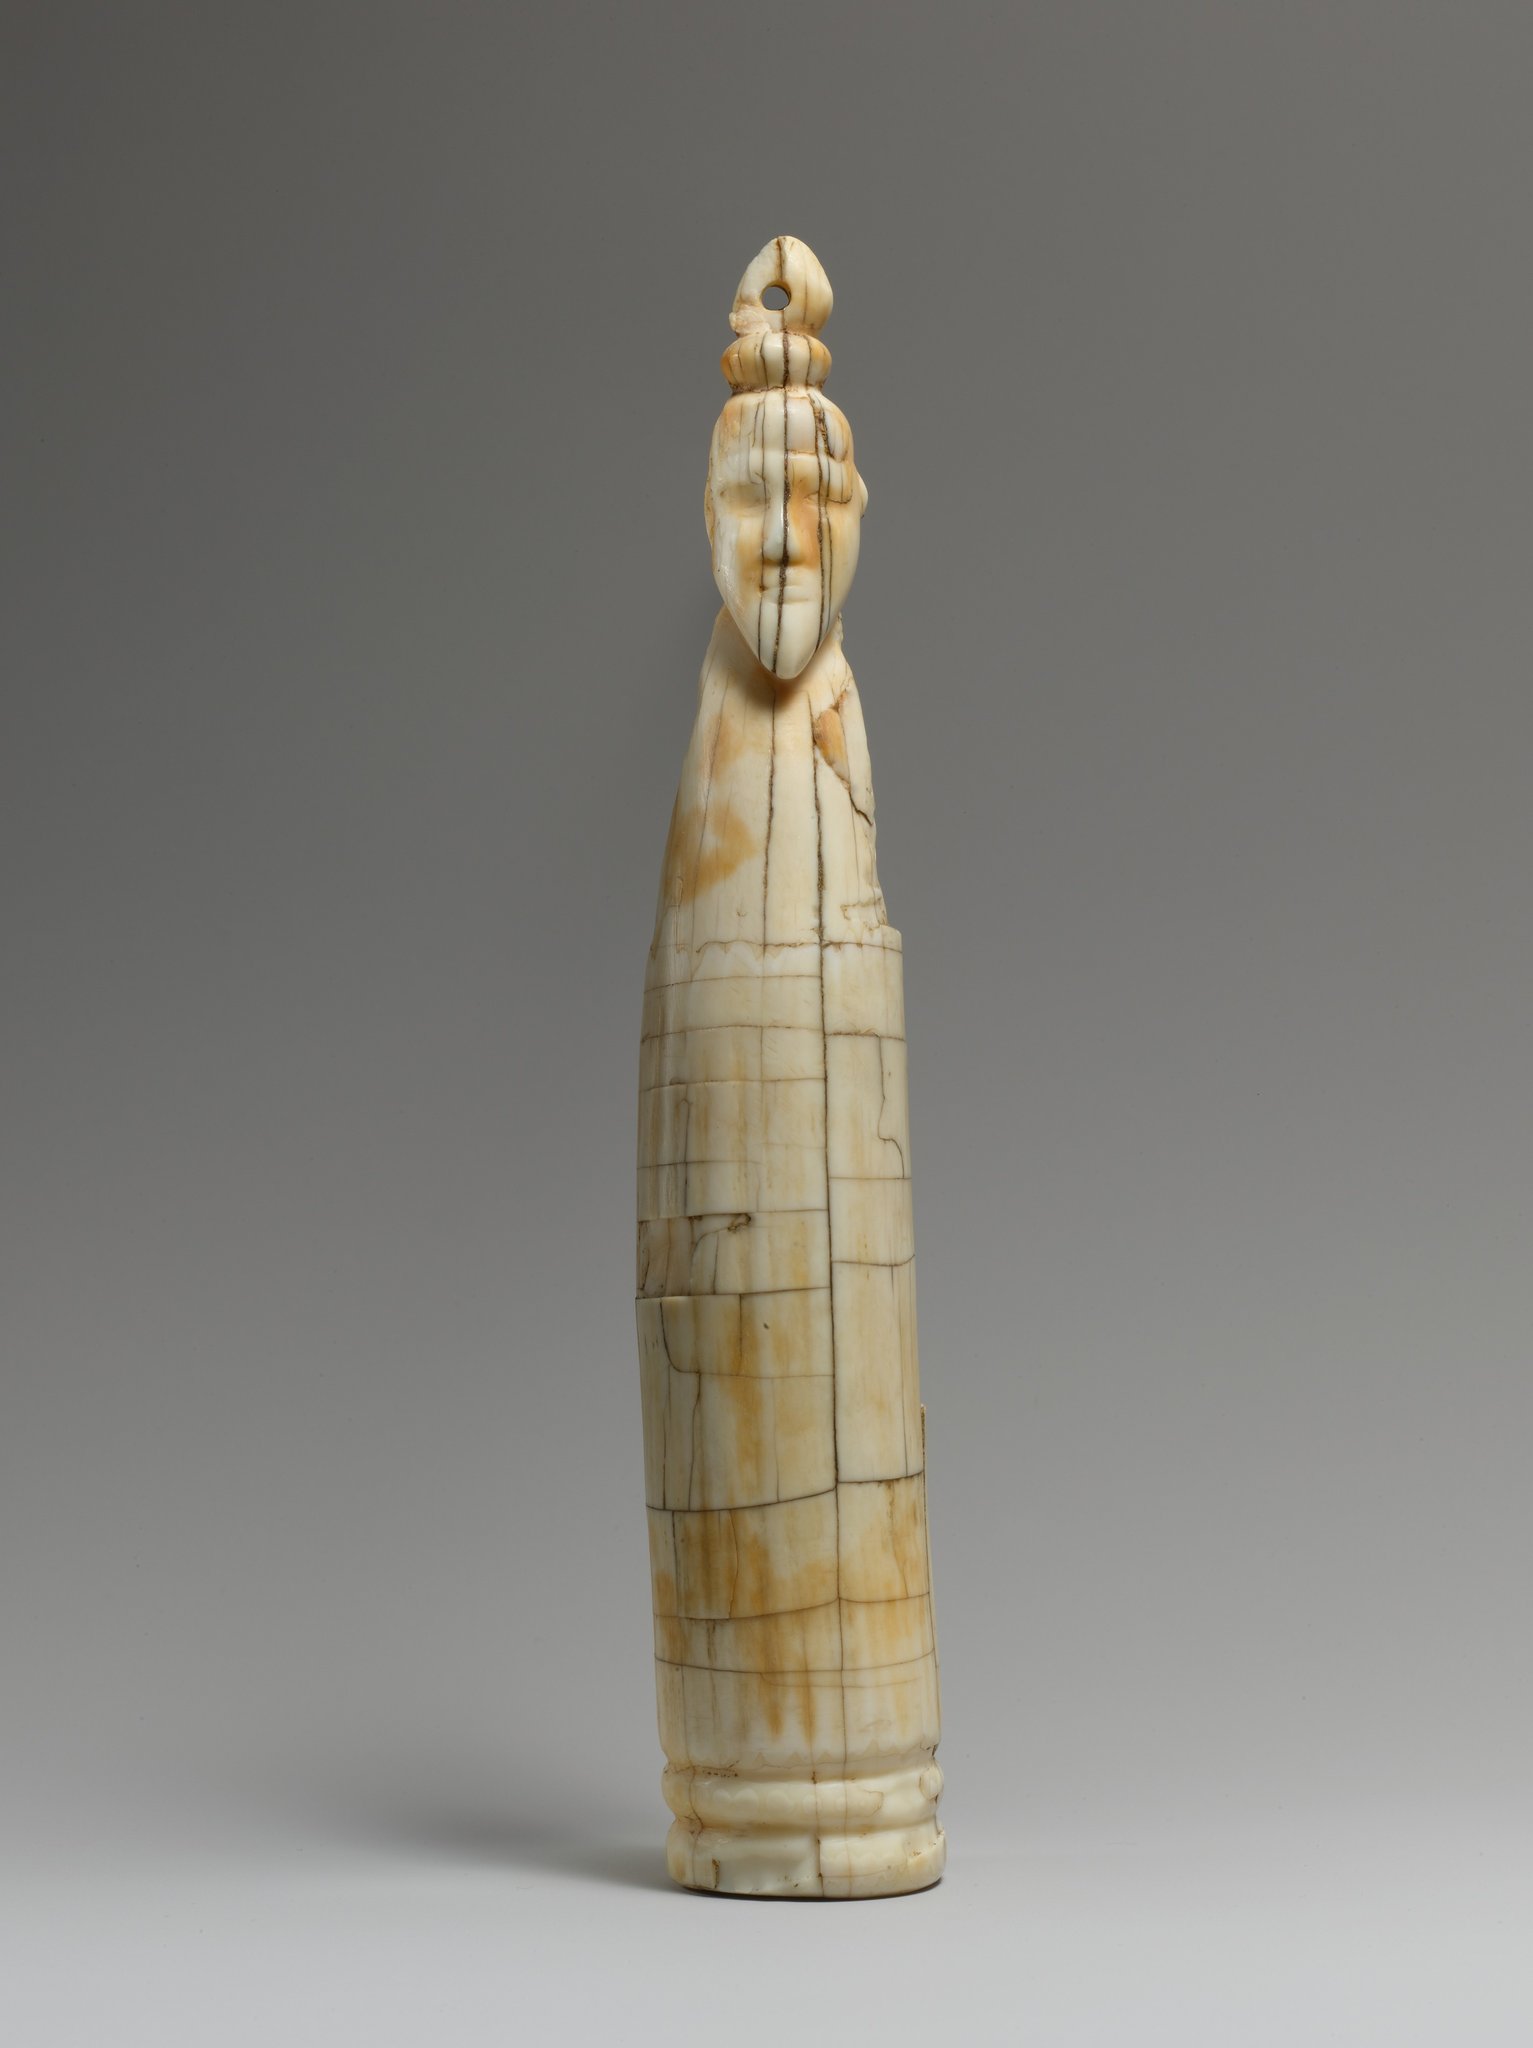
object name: statuette, tusk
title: Tusk figure of a man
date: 3900-3500 BCE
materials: ivory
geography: egypt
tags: men